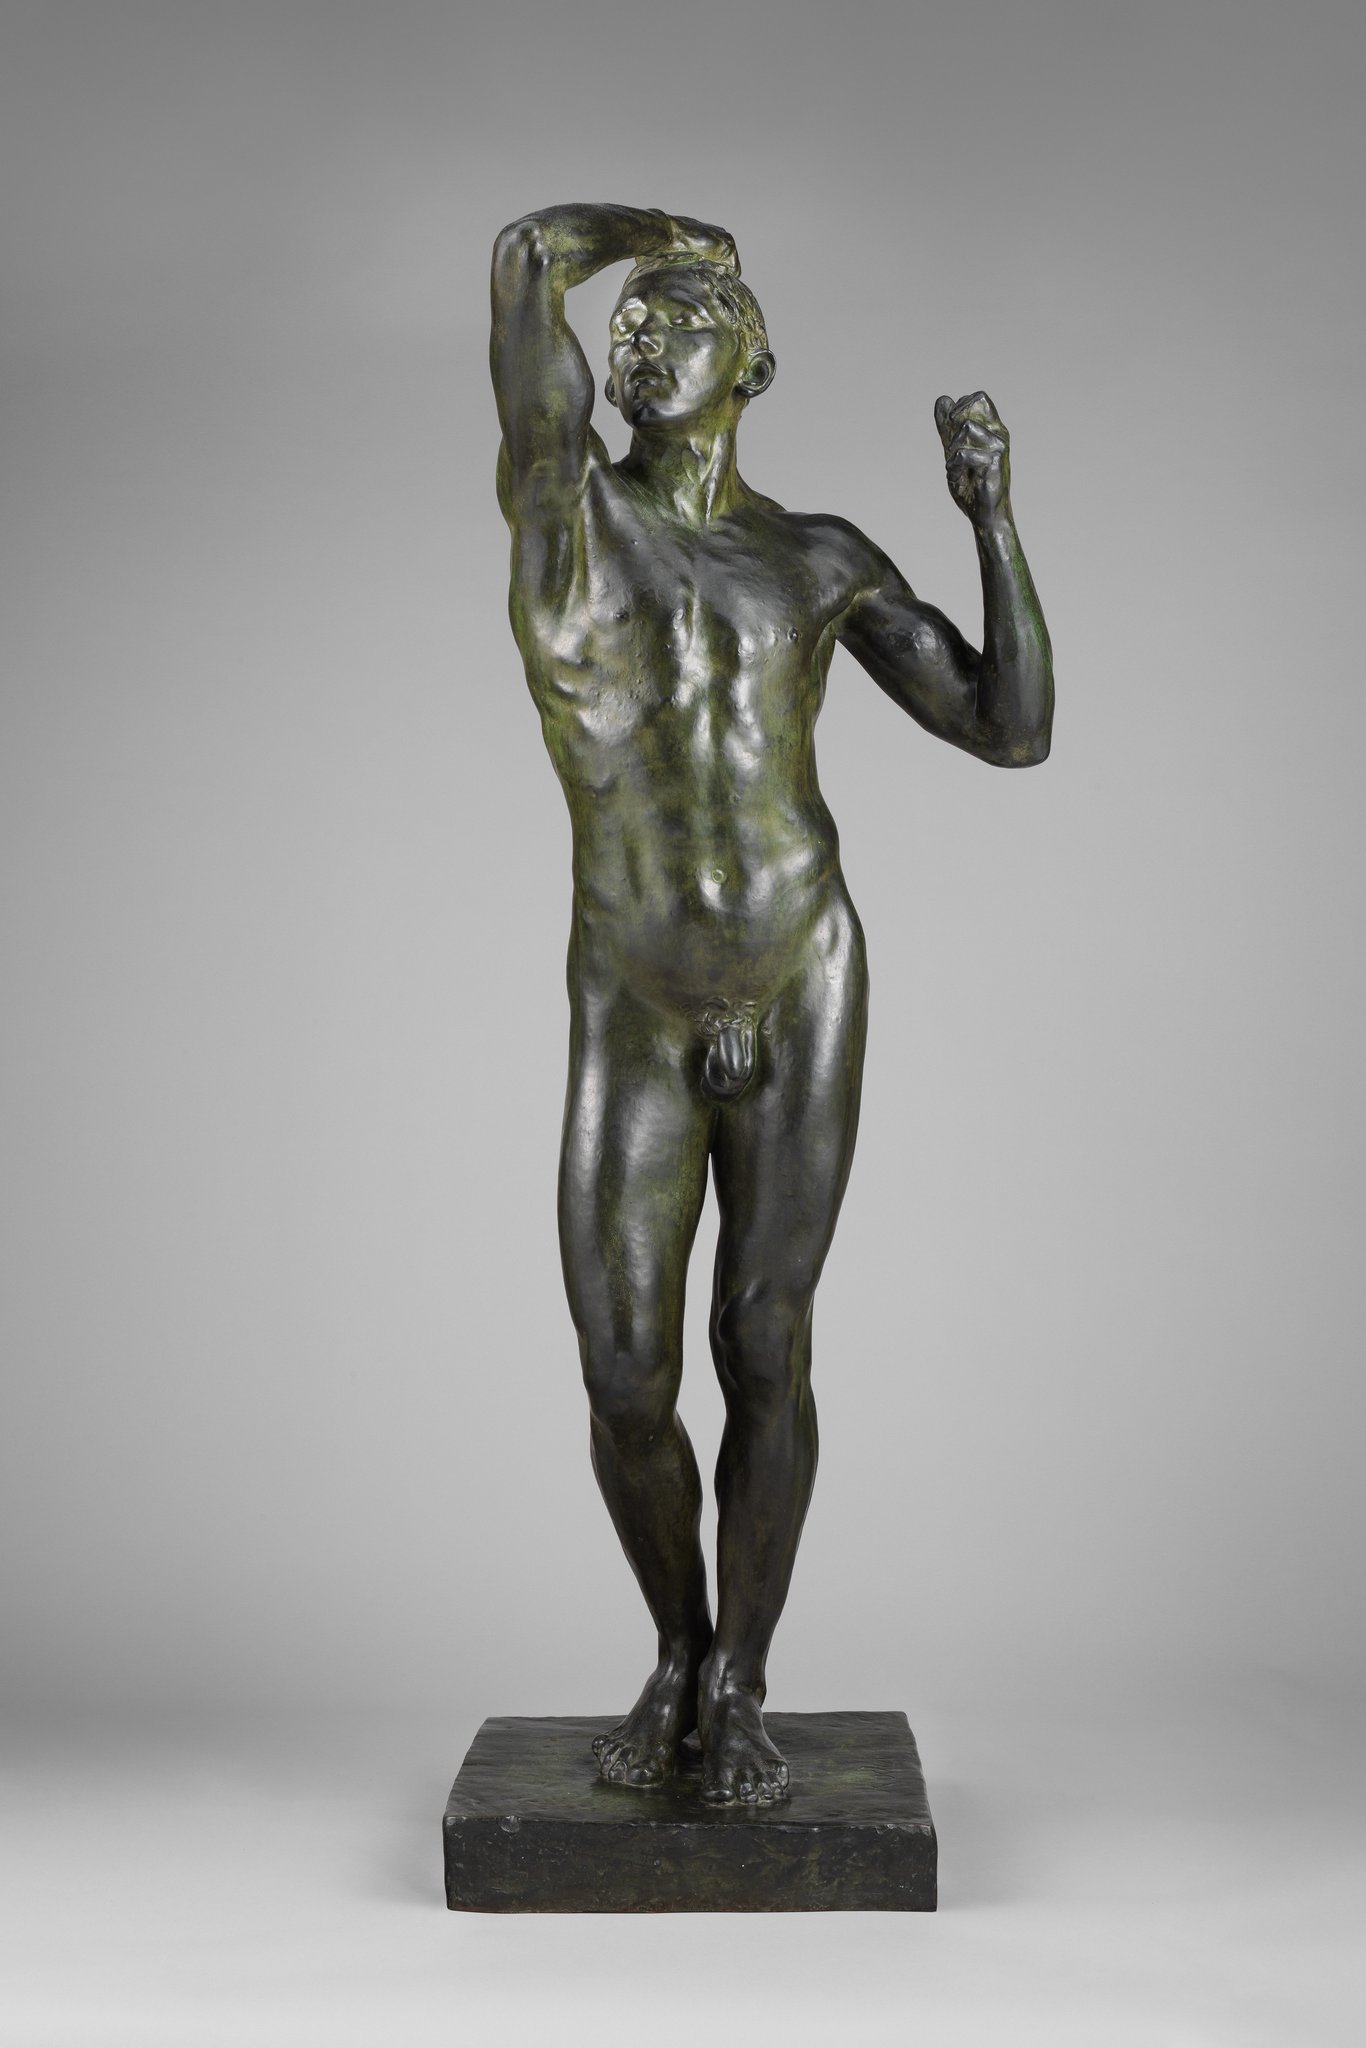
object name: statue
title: The Age of Bronze (L'Age d'airain)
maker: auguste rodin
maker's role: artist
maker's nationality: french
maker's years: 1840-1917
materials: bronze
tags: male nudes